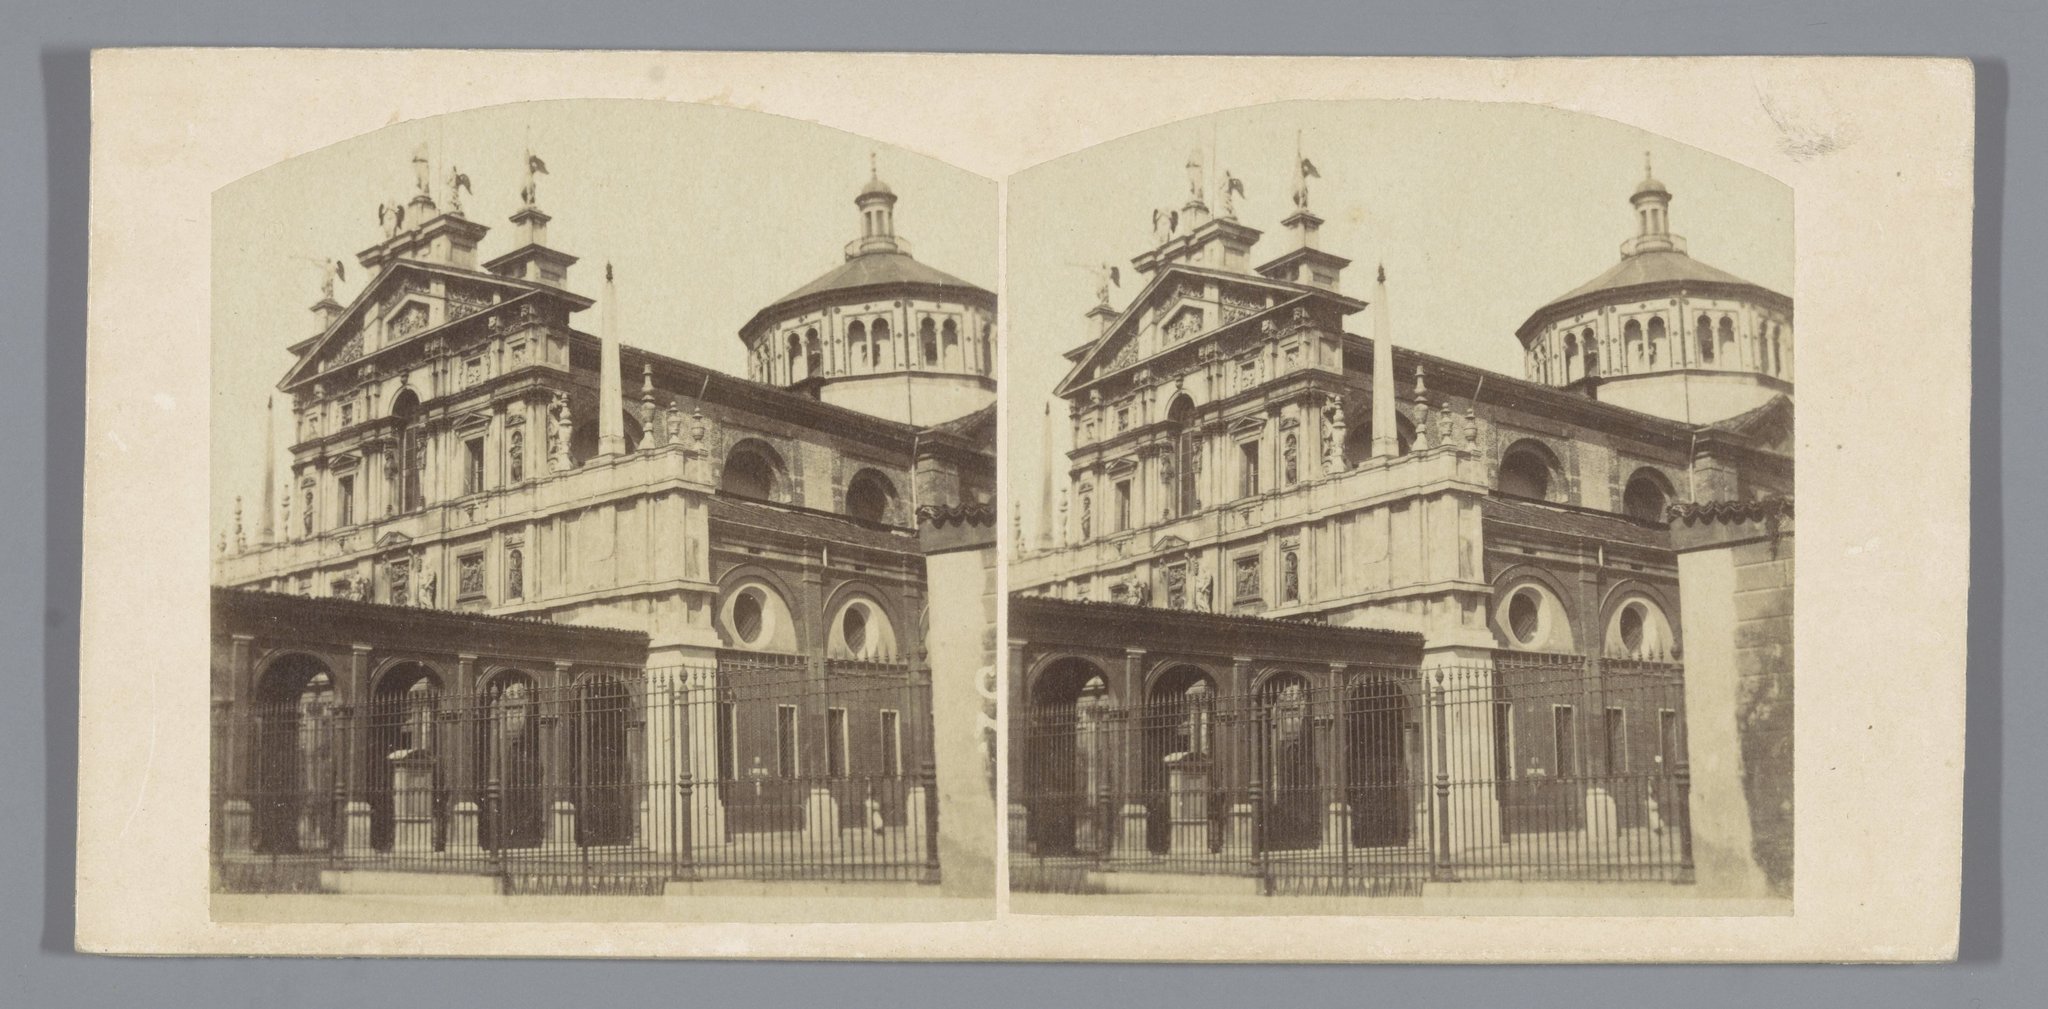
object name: stereograph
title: Exterieur van de Santa Maria delle Grazie te Milaan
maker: Anonymous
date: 1850-1880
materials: cardboard, photographic support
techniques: albumen print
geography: milan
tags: church (exterior), façade (of house or building)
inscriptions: inscription: ‘La chiesa delle Grazie Milan’